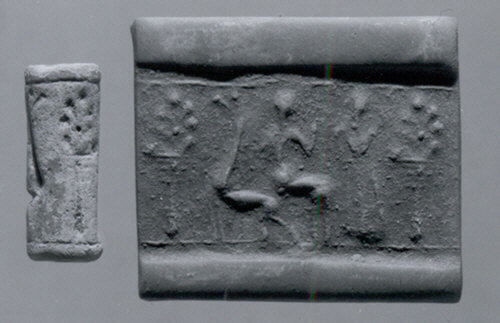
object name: cylinder seal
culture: mitanni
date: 1600-1301 BCE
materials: limestone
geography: mesopotamia